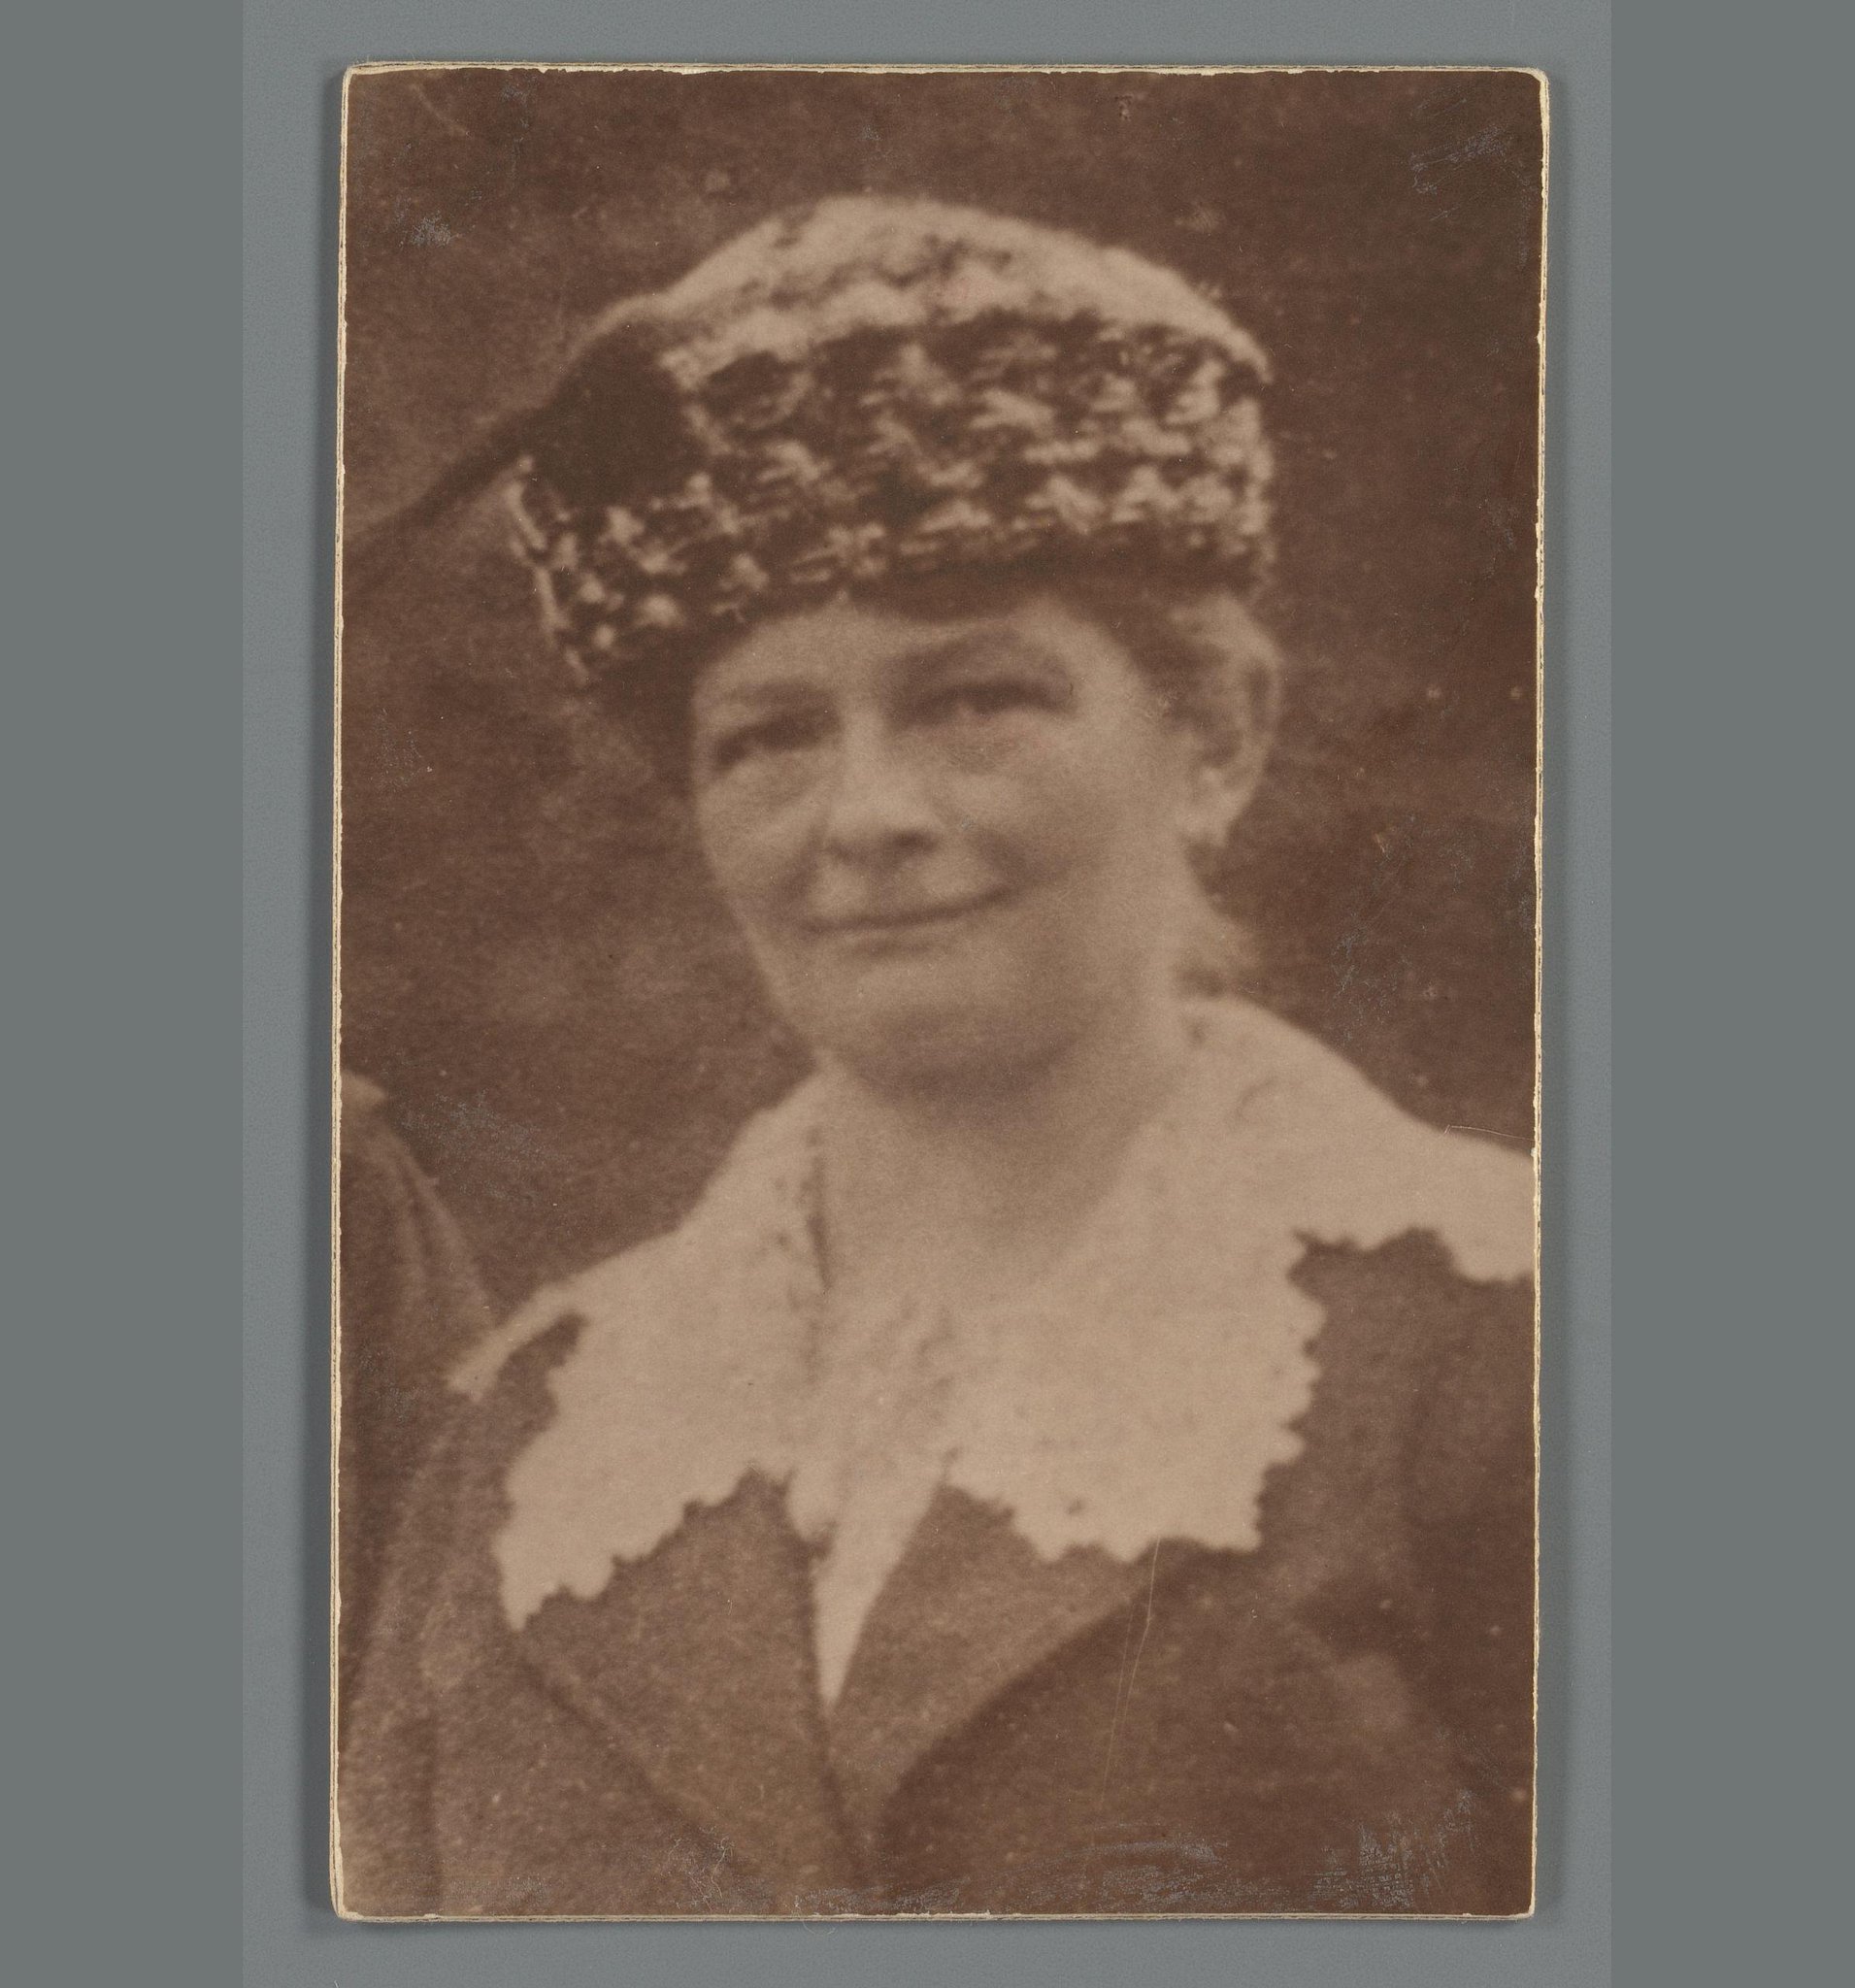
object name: photograph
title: Portret van Corry Merks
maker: Anonymous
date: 1905-1920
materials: paper, cardboard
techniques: gelatin silver print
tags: historical persons - bb - woman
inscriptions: inscription: ‘Corry Merks ?’